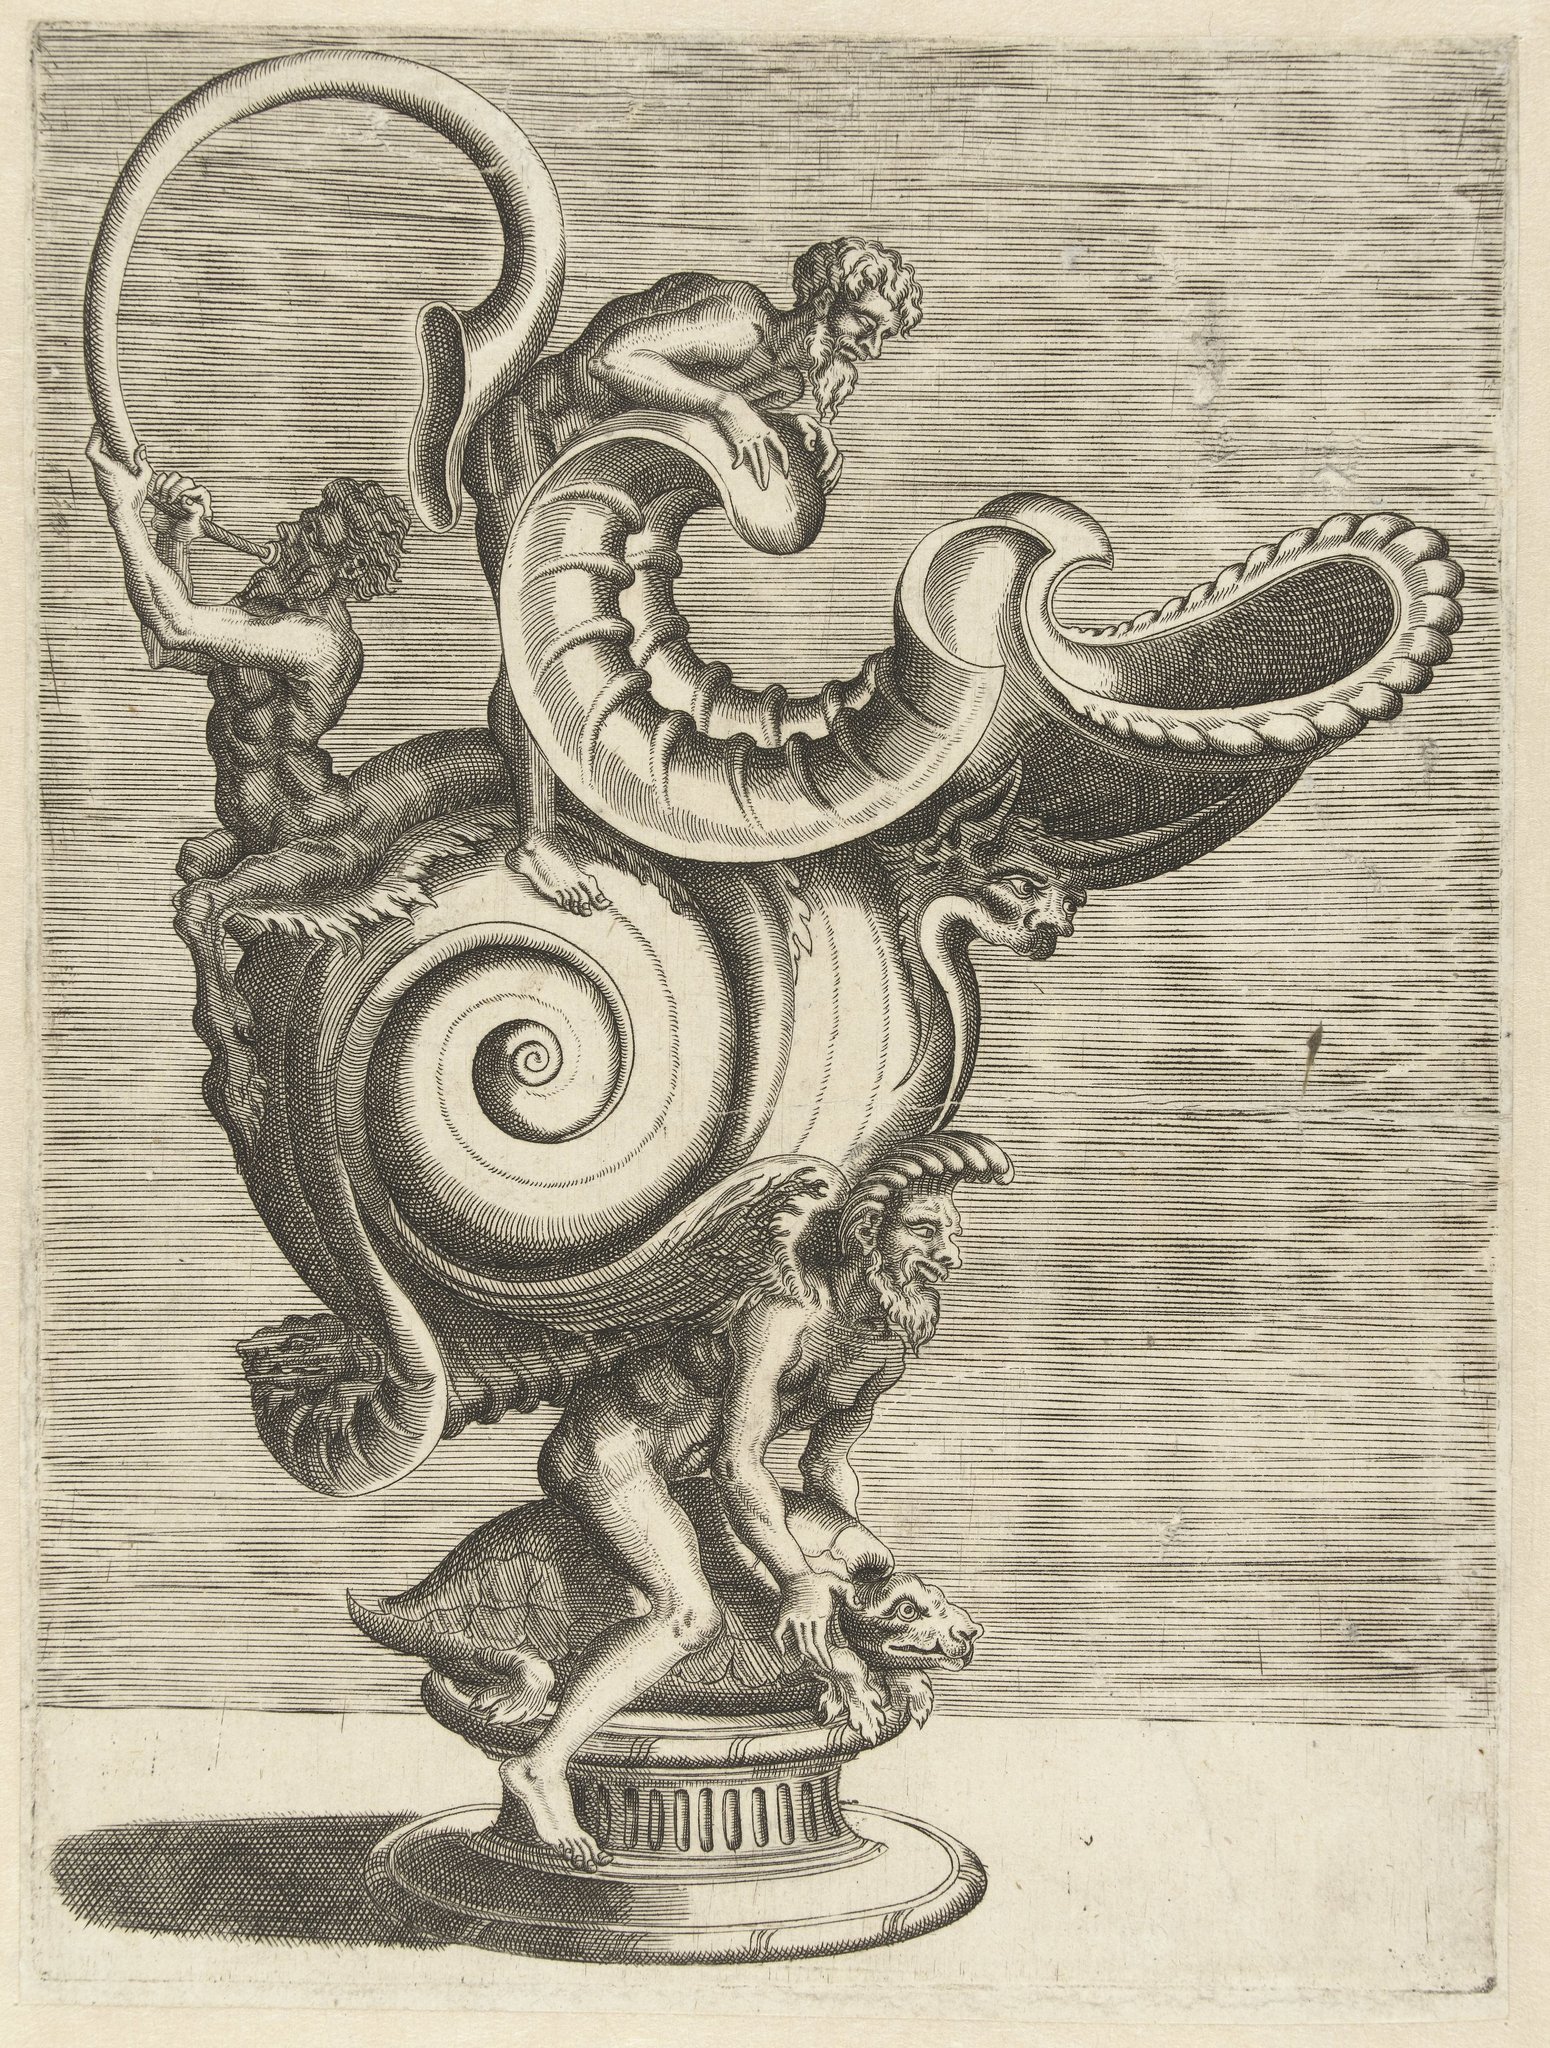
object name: print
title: Kan in de vorm van een slakkenhuis, rustend op de rug van een man die op een schildpad zit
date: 1548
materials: paper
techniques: engraving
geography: netherlands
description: Het oor van de kan bestaat uit een hoorn waarop een sater blaast die op het slakkenhuis zit. Het andere einde van de hoorn rust op de rug van een man die over de schelpvormige tuit gebogen staat. Afkomstig uit een serie bestaande uit een titelblad en 20 bladen.